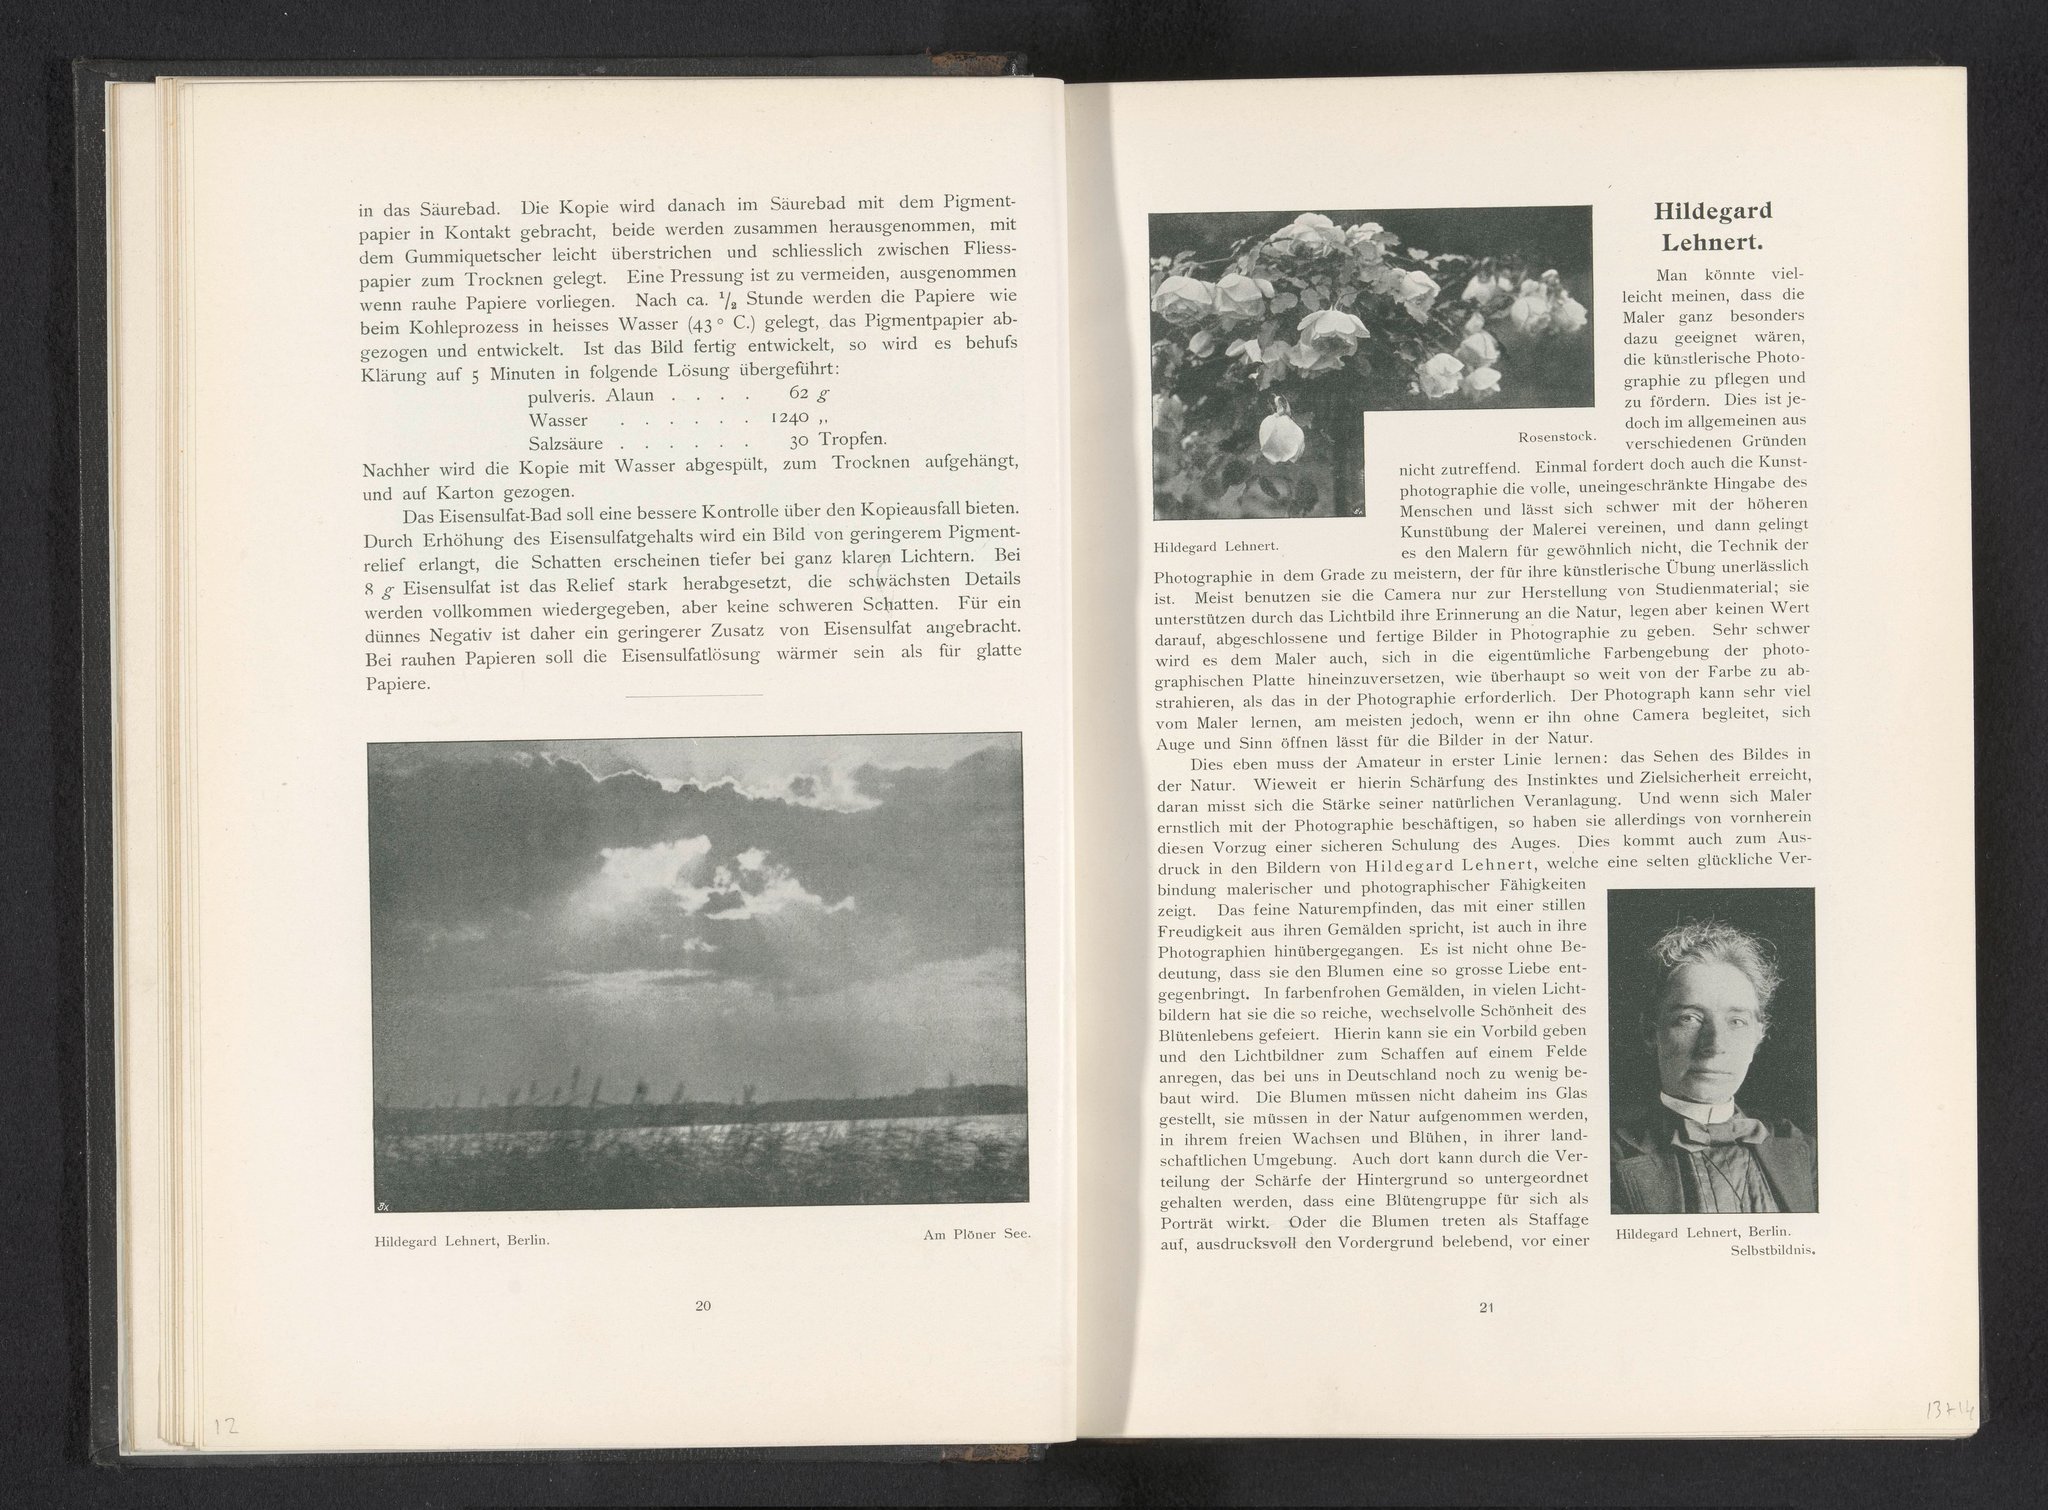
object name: page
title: Zelfportret van Hildegard Lehnert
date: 1898-1903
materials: paper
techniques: autotype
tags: berlin, painter, hildegard lehnert, historical persons - bb - woman